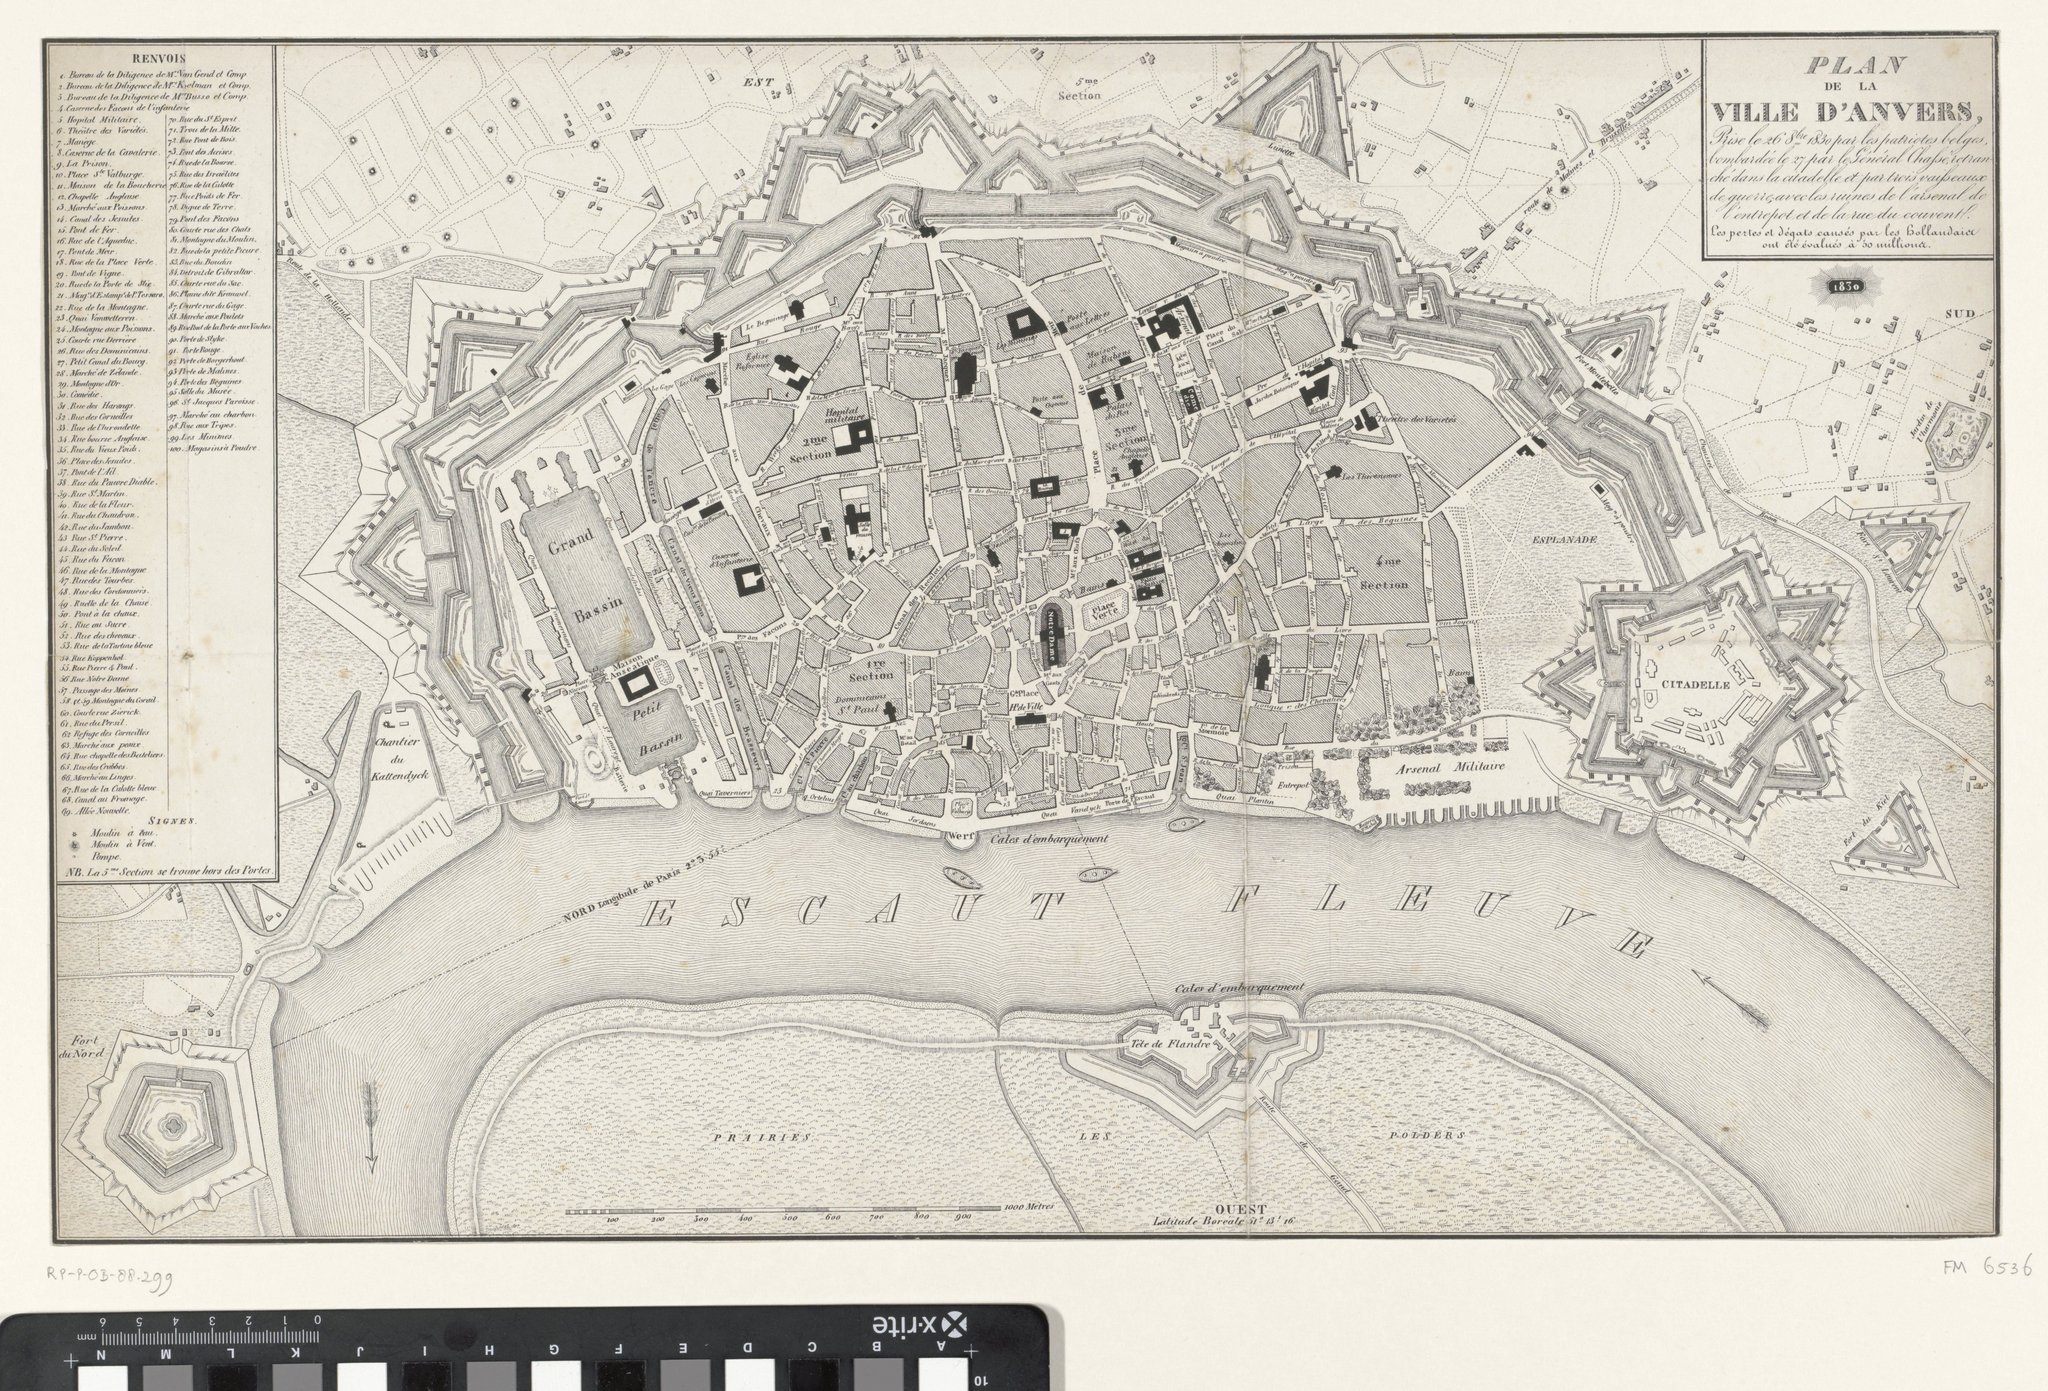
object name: map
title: Plattegrond van Antwerpen en de Citadel, 1830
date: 1830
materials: paper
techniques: lithograph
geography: brussels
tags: maps of cities, antwerp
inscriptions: collector's mark: Lugt 2228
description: Plattegrond van de stad Antwerpen met de Citadel, na het bombardement door de Nederlanders op 27 oktober 1830. De verwoestingen in de stad bij het arsenaal en entrepot aangegeven door middel van arcereingen. Links in een kader de legenda 1-100.